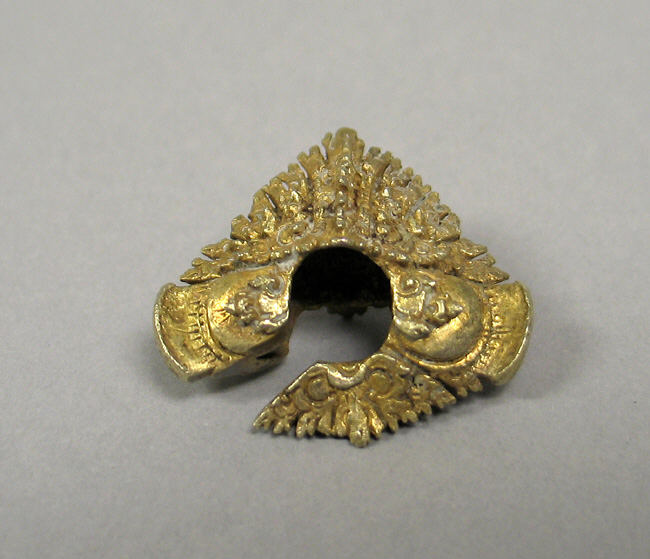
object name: ear ornament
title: Ear Ornament, Arrow Head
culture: indonesian, central java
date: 701-1200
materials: gold